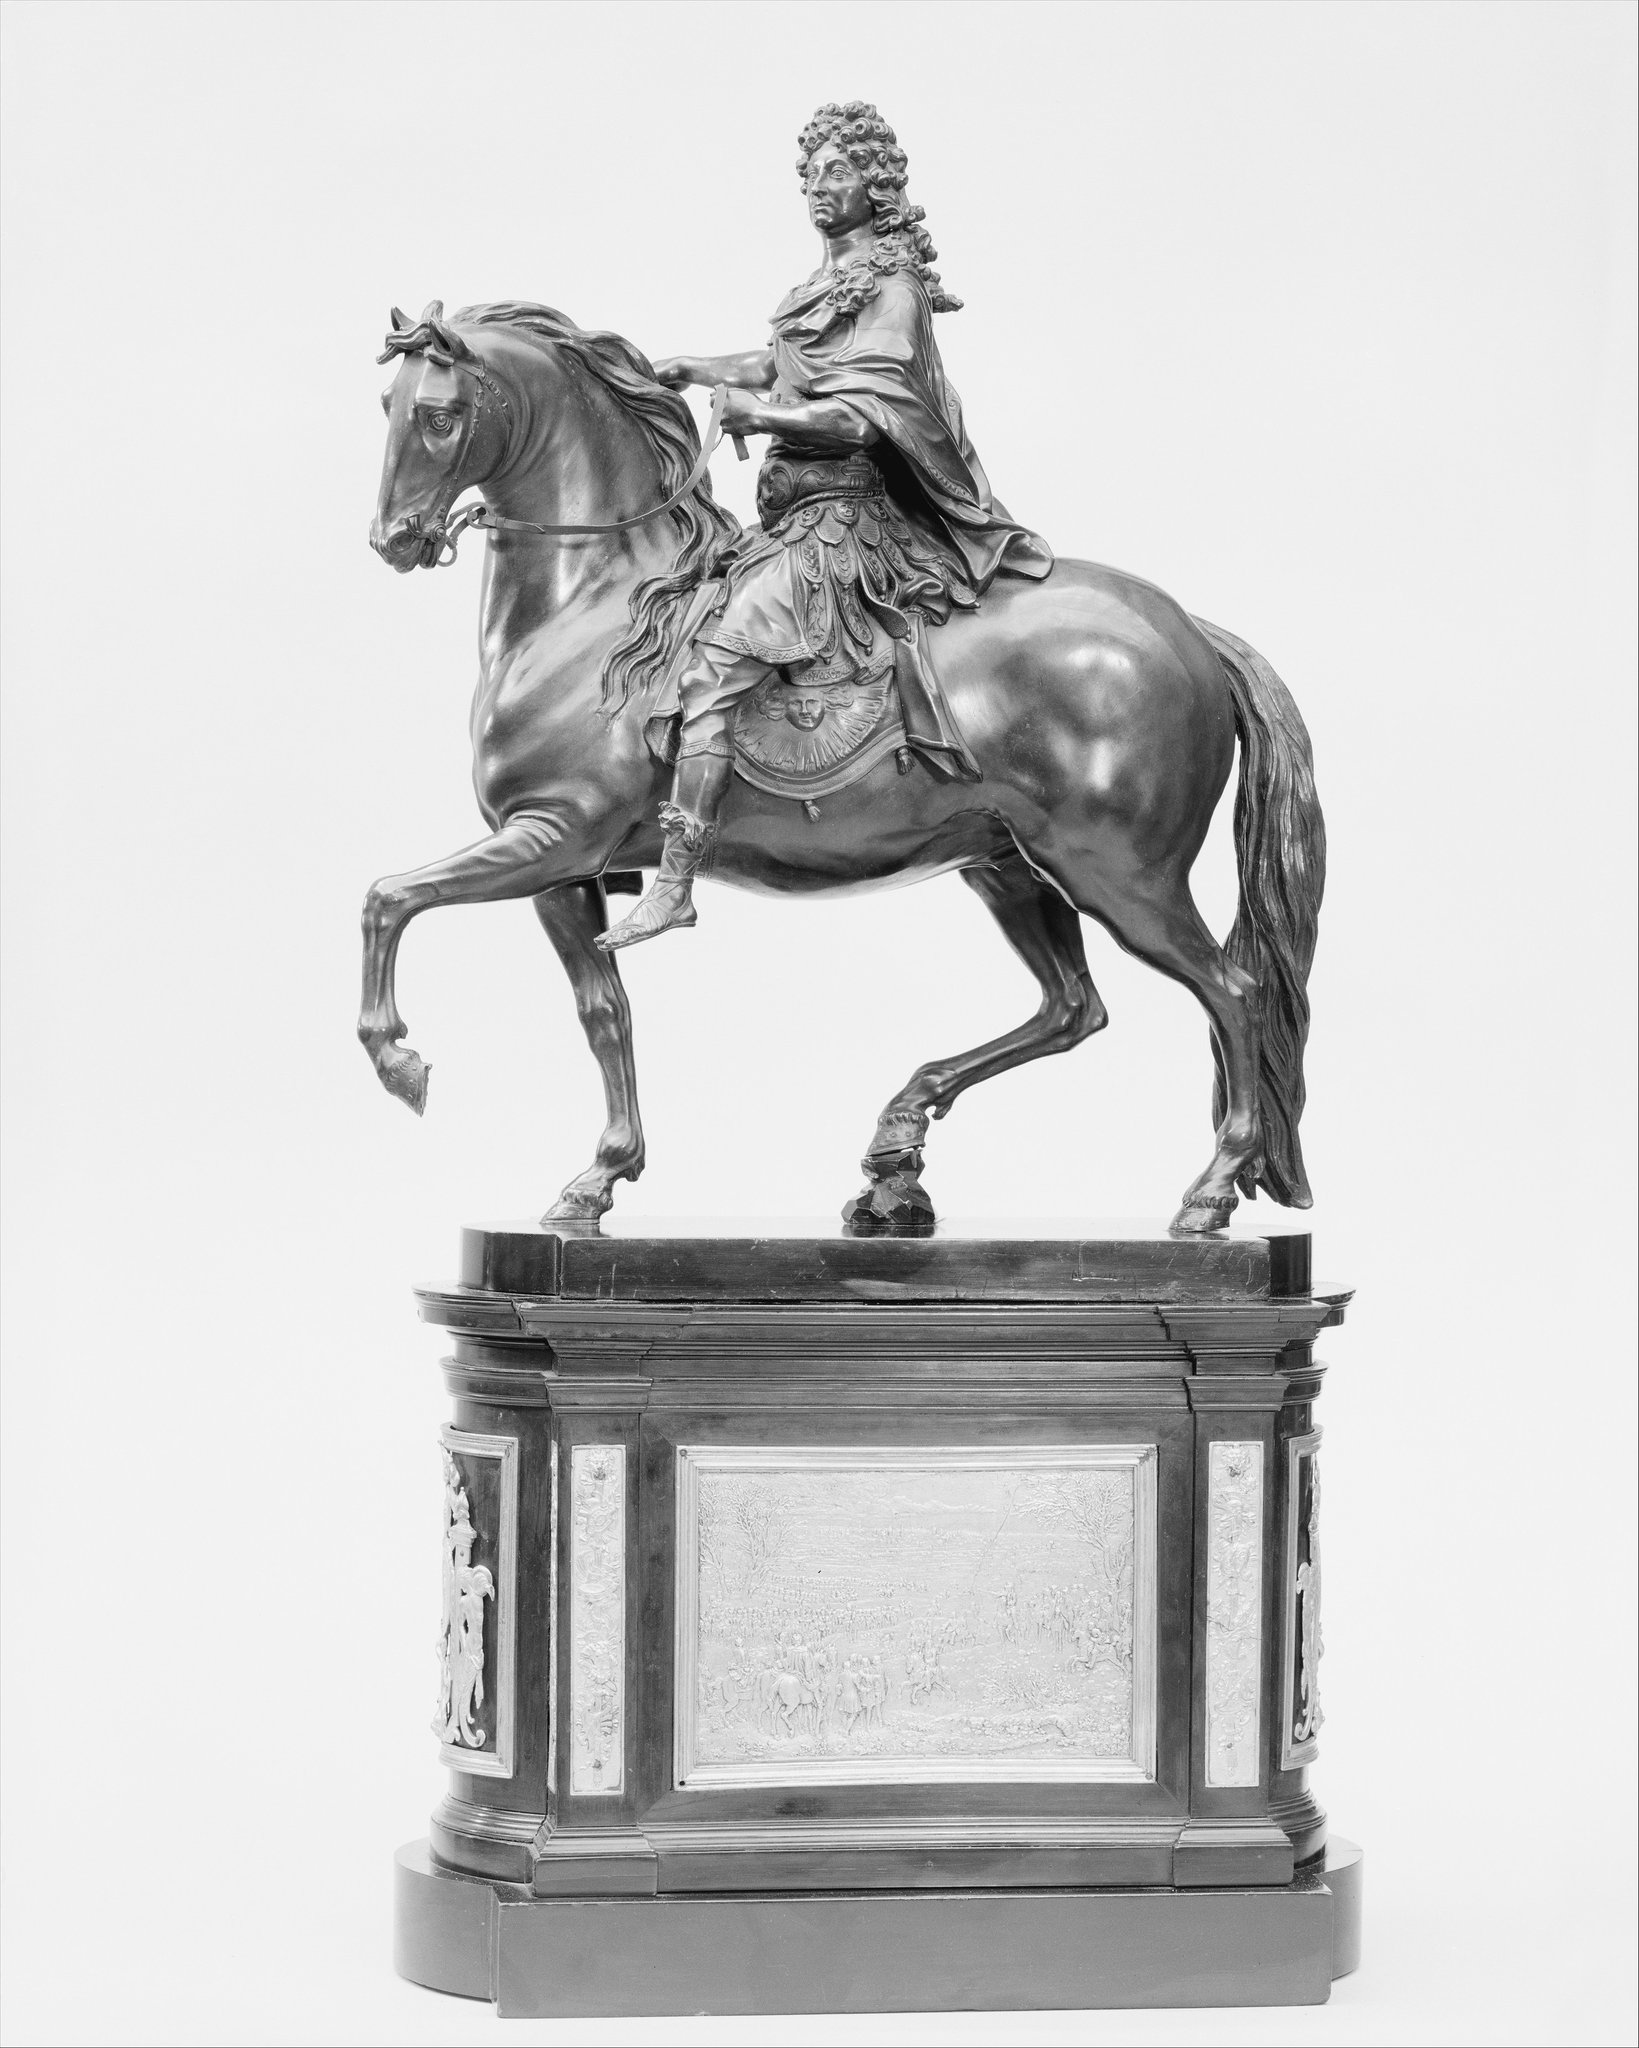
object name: statuette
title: Louis XIV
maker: martin van den bogaert called desjardins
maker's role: artist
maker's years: 1640-1694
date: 1701-1733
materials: bronze, gilt bronze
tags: kings,louis xiv,horses